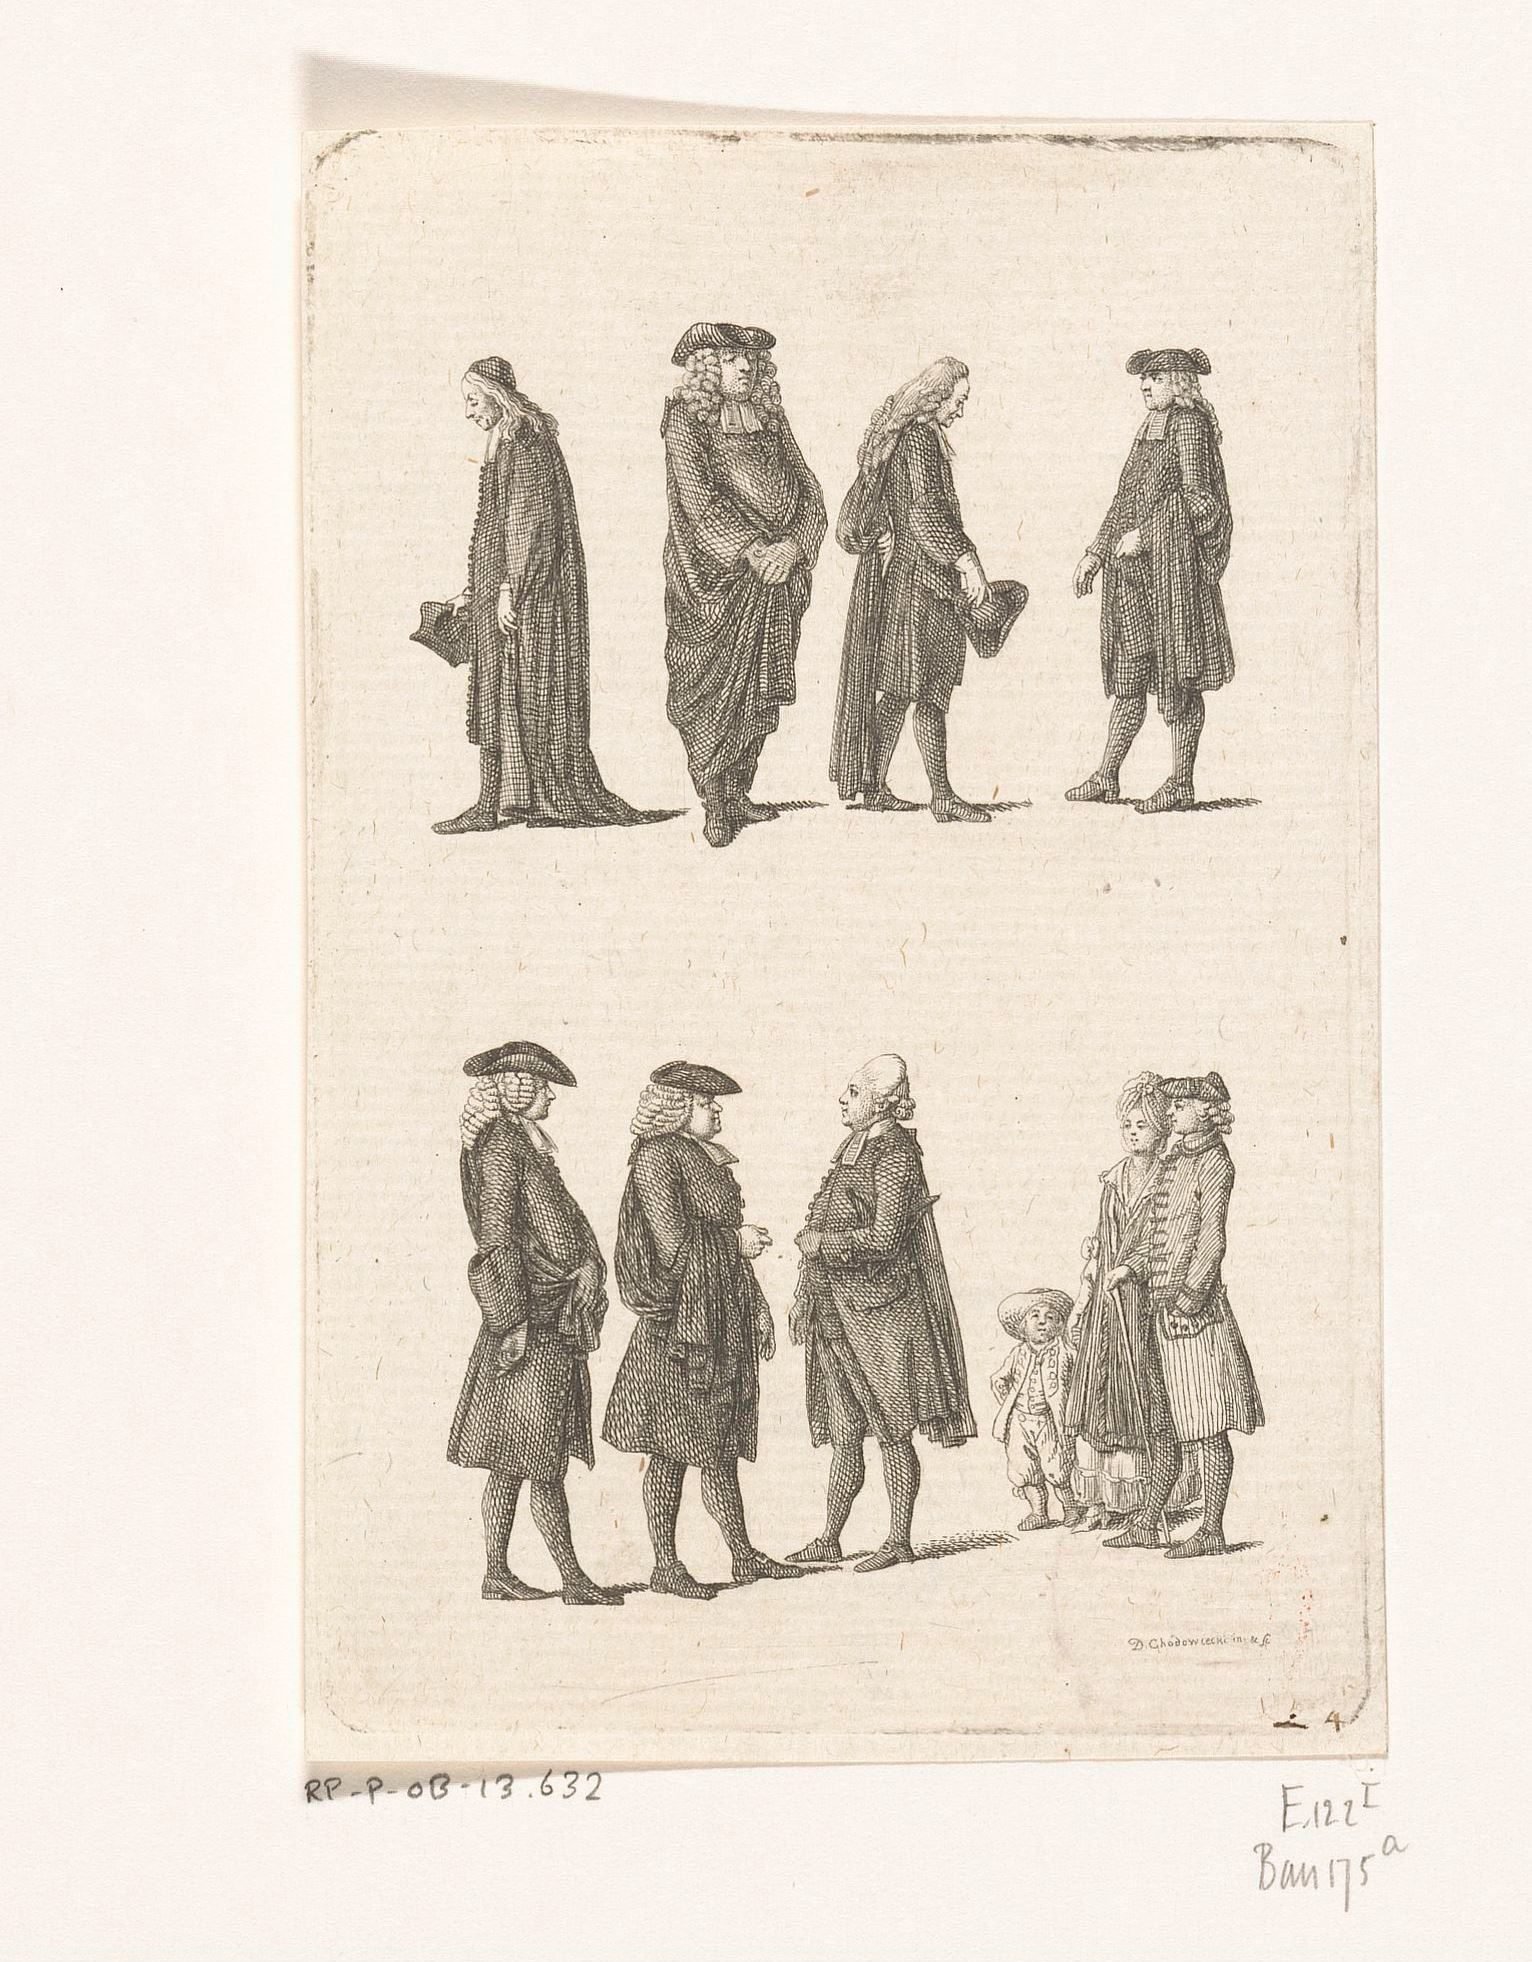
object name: print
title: Predikanten in ambtskleding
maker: daniel nikolaus chodowiecki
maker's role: draughtsman, print maker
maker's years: 1726-1801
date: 1775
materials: paper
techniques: etching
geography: berlin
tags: berlin, publisher, friedrich nicolai, literature, functionaries and dignitaries ~ episcopal protestant churches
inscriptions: inscription: ‘- 4’, collector's mark: Lugt 240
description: Deze scène behoort tot een serie prenten die het verhaal van Sebaldus Nothanker door Friedrich Nicolai illustreren. De tweede staat van deze prent is gebruikt in: [Nicolai Friedrich]. Das Leben und die Meinungen des Herrn Magister Sebaldus Nothanker. Berlijn en Stettin: Friedrich Nicolai, 1776 [eerste editie], dl. 2.